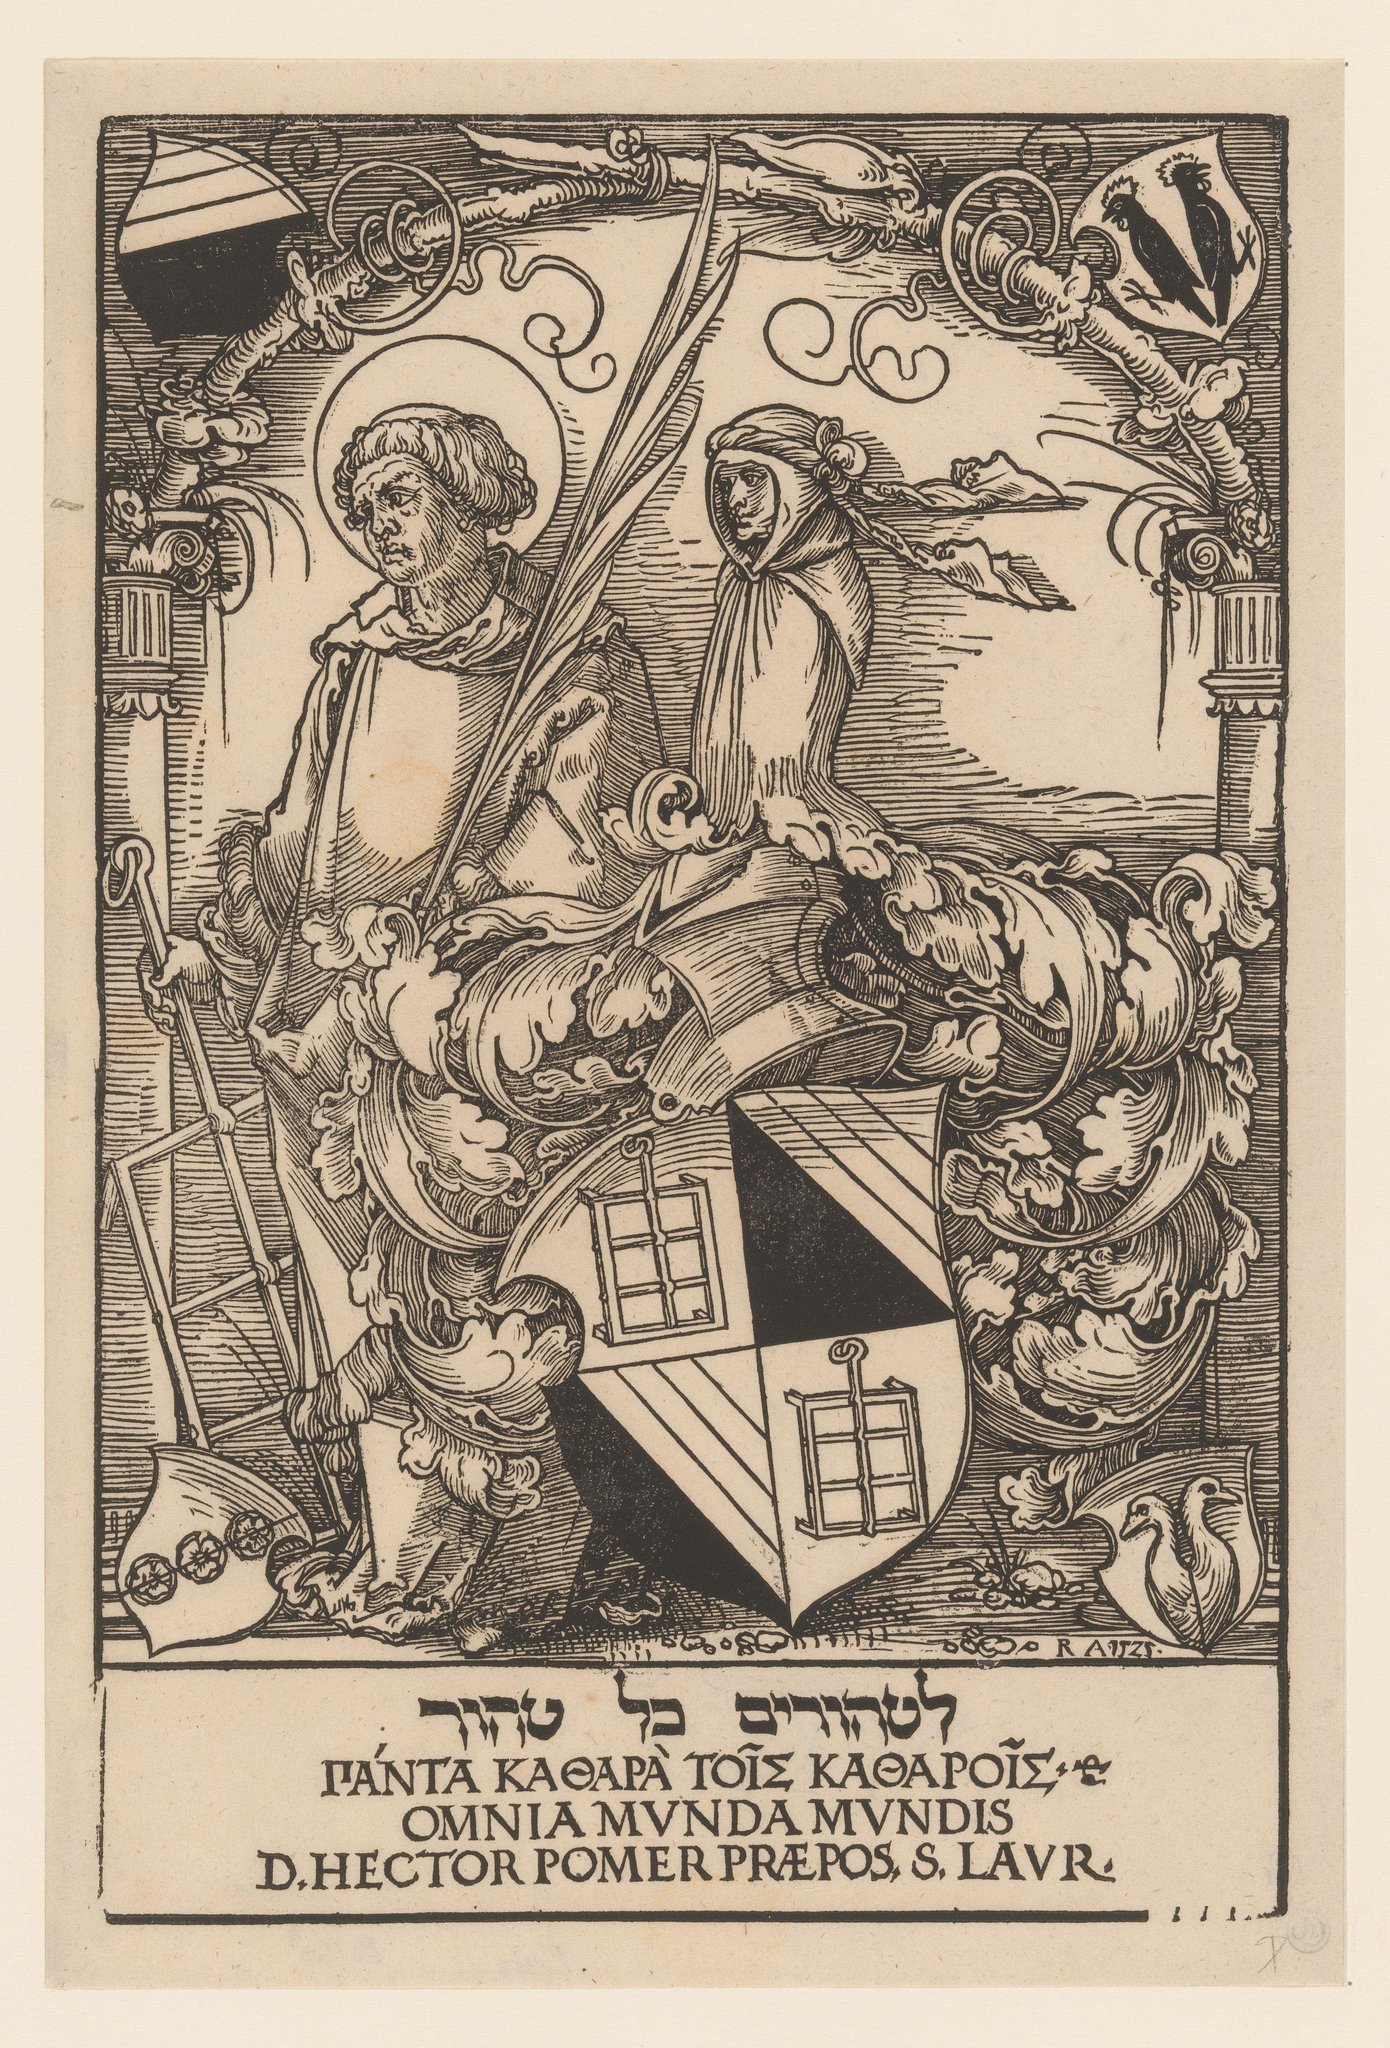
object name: print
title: Familiewapen van Hektor Poemer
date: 1525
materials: paper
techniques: woodcut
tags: armorial bearing, heraldry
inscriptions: collector's mark: Lugt 1185, collector's mark: Lugt 2228, collector's mark: ‘J.A. Borrner’, collector's mark: Lugt 529